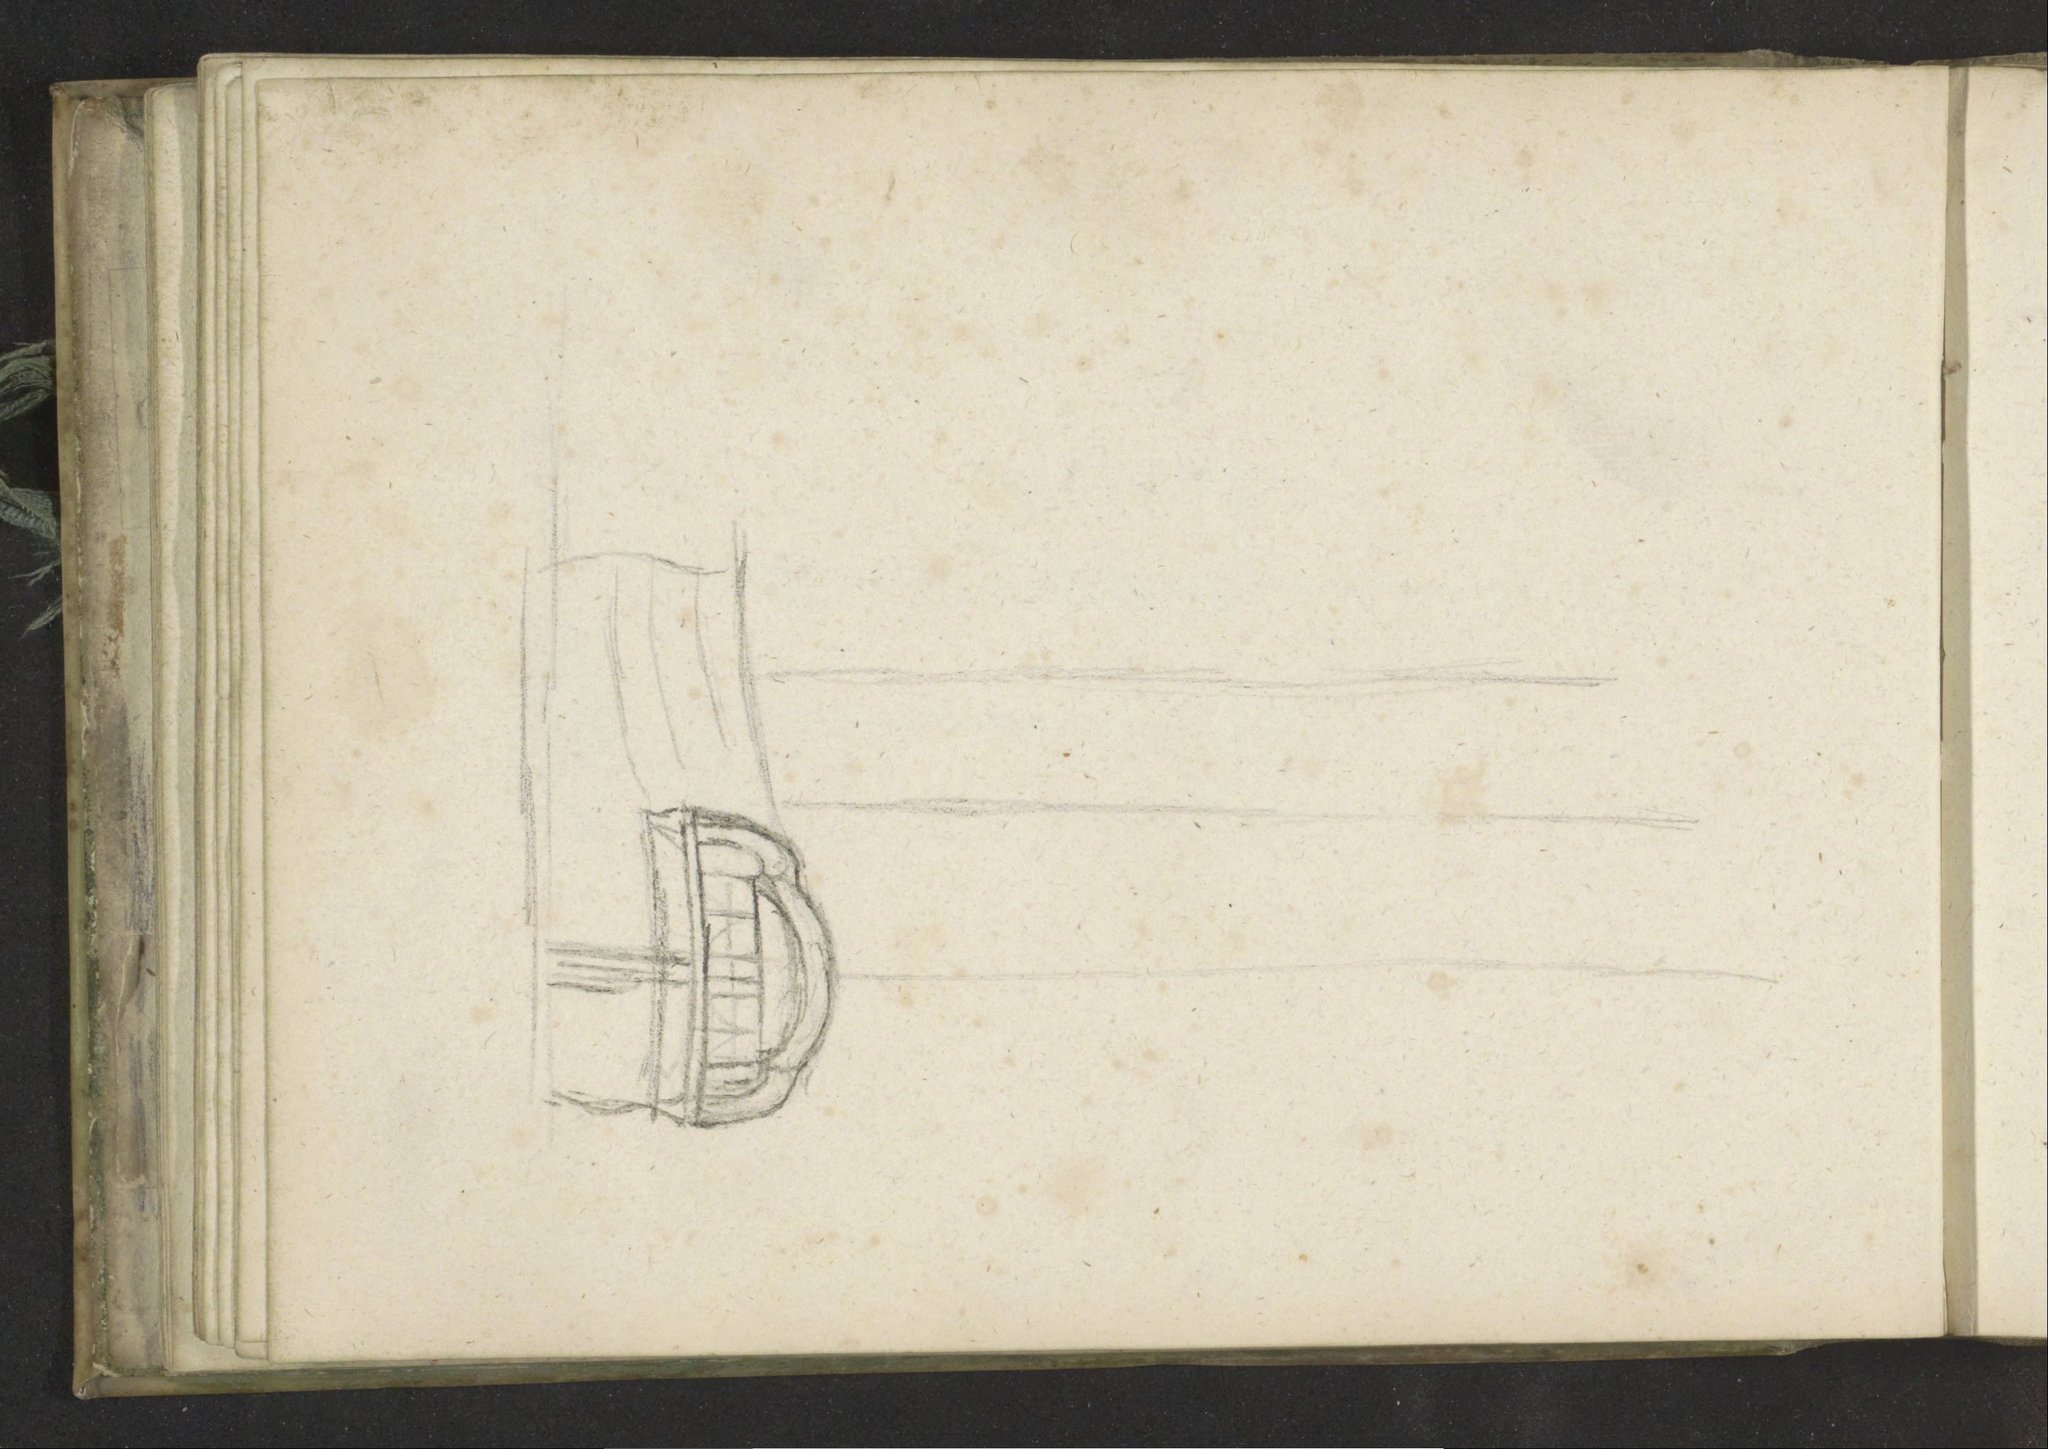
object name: sketchbook leaf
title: Zeilschip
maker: martinus schouman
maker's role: draughtsman, painter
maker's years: 1770-1848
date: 1780-1848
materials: paper, pencil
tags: sailing-ship, sailing-boat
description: Blad 24 verso uit een schetsboek met 53 bladen.